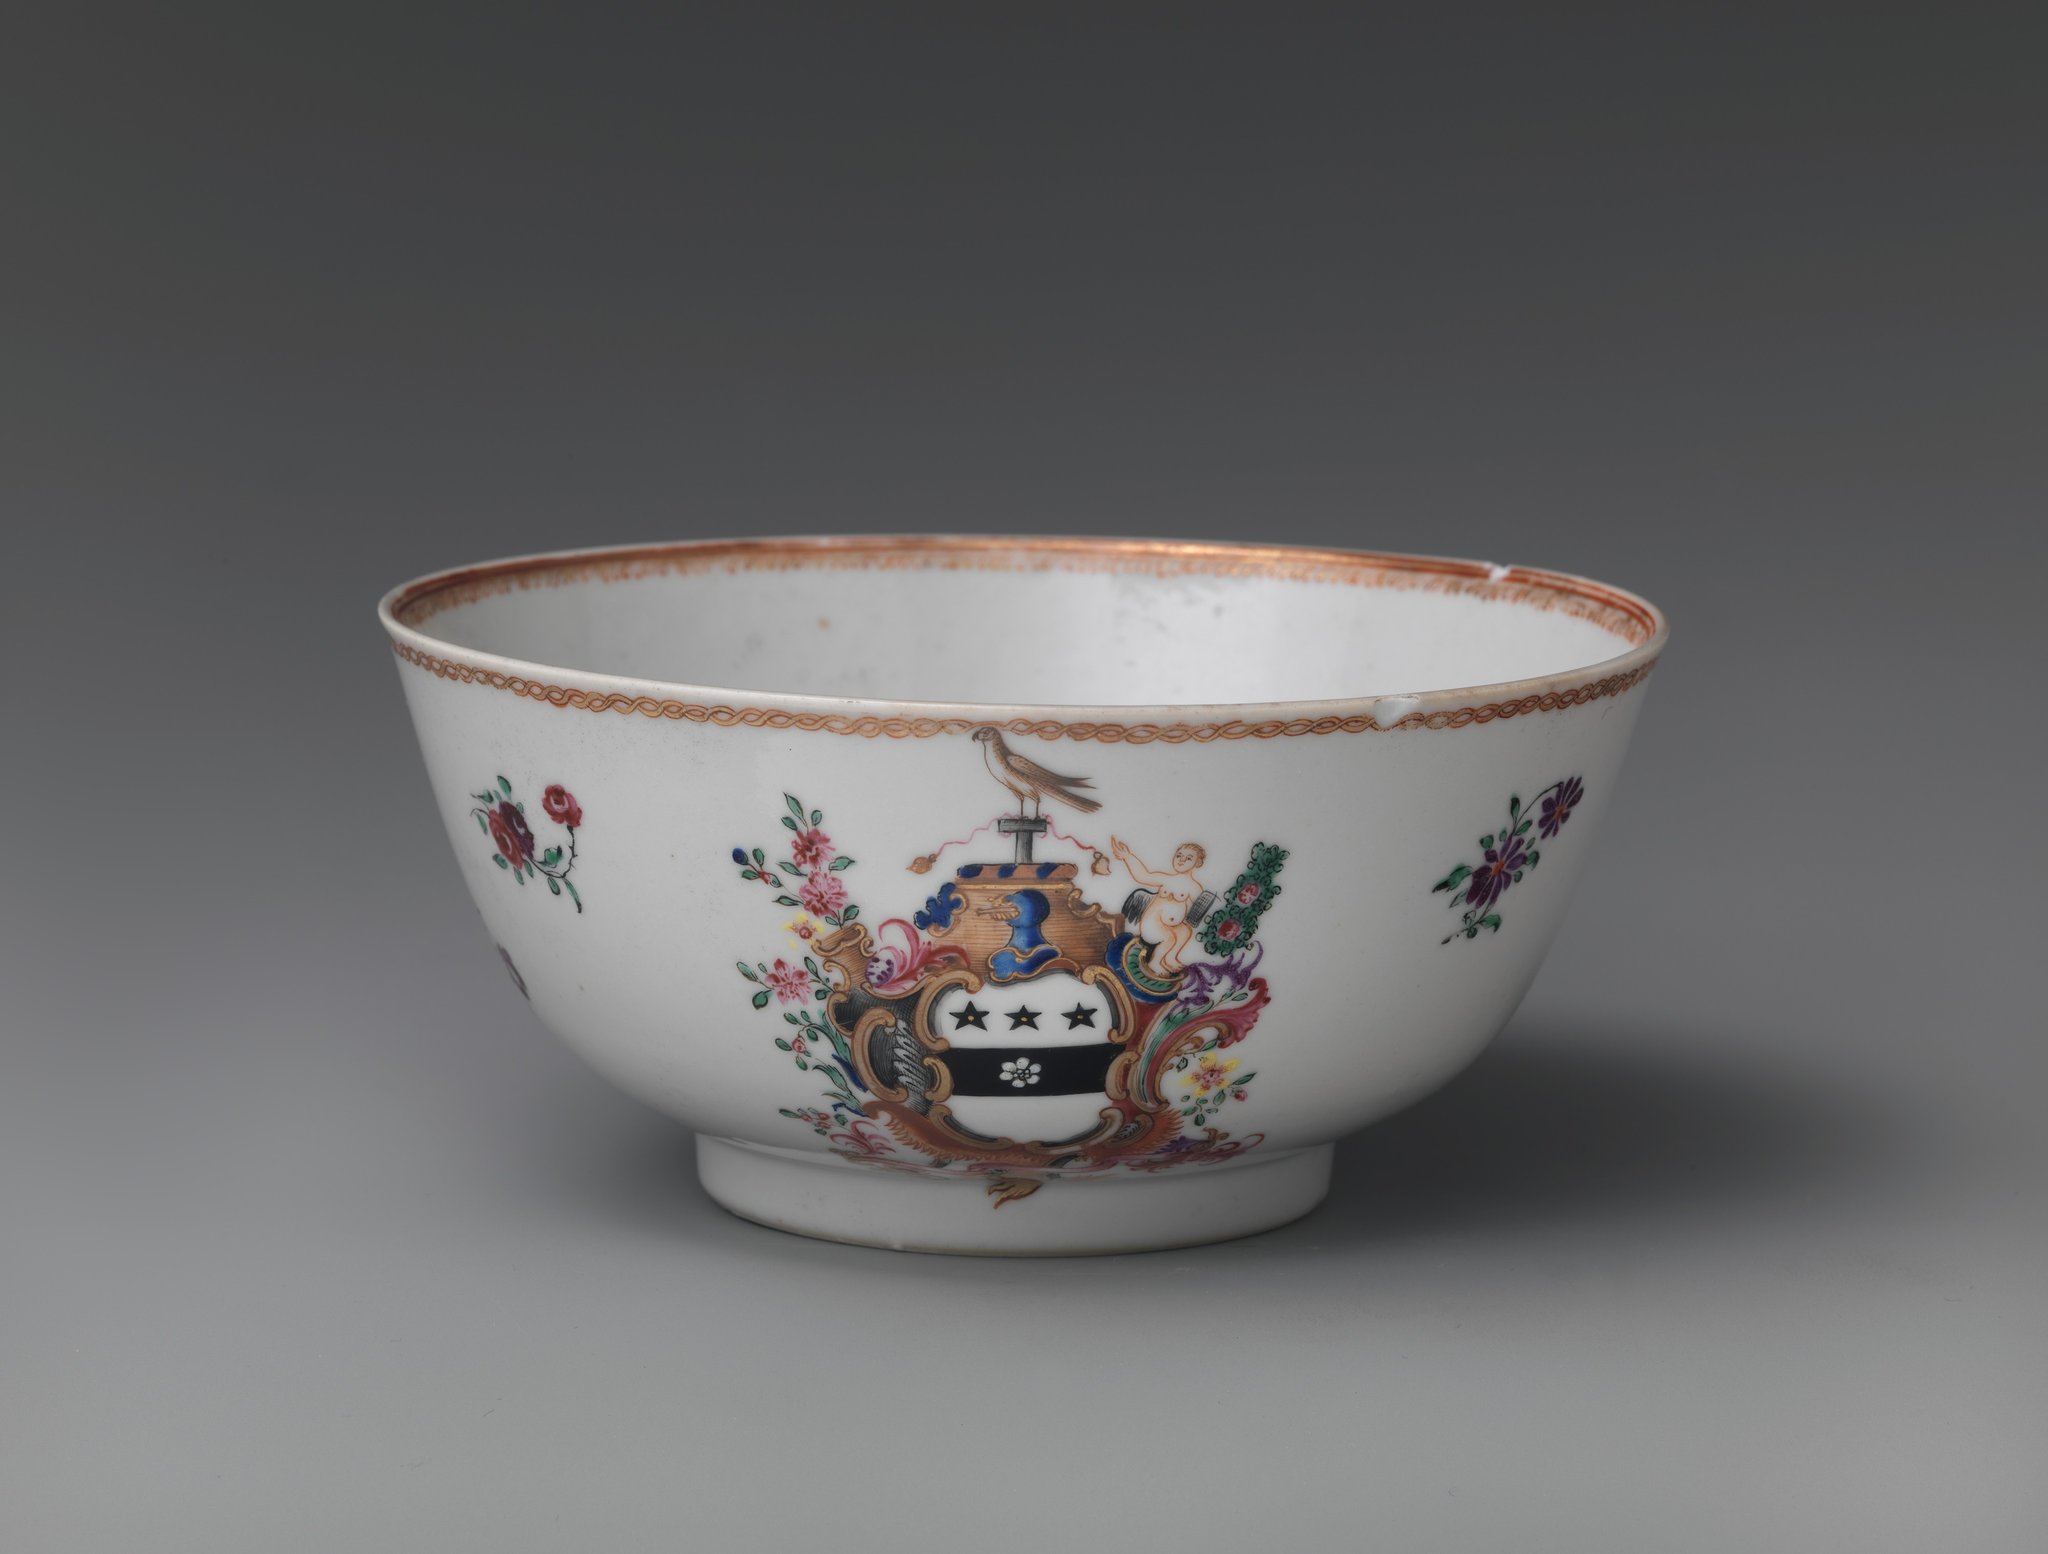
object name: bowl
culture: chinese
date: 1785-1790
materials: porcelain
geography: china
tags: birds,coat of arms